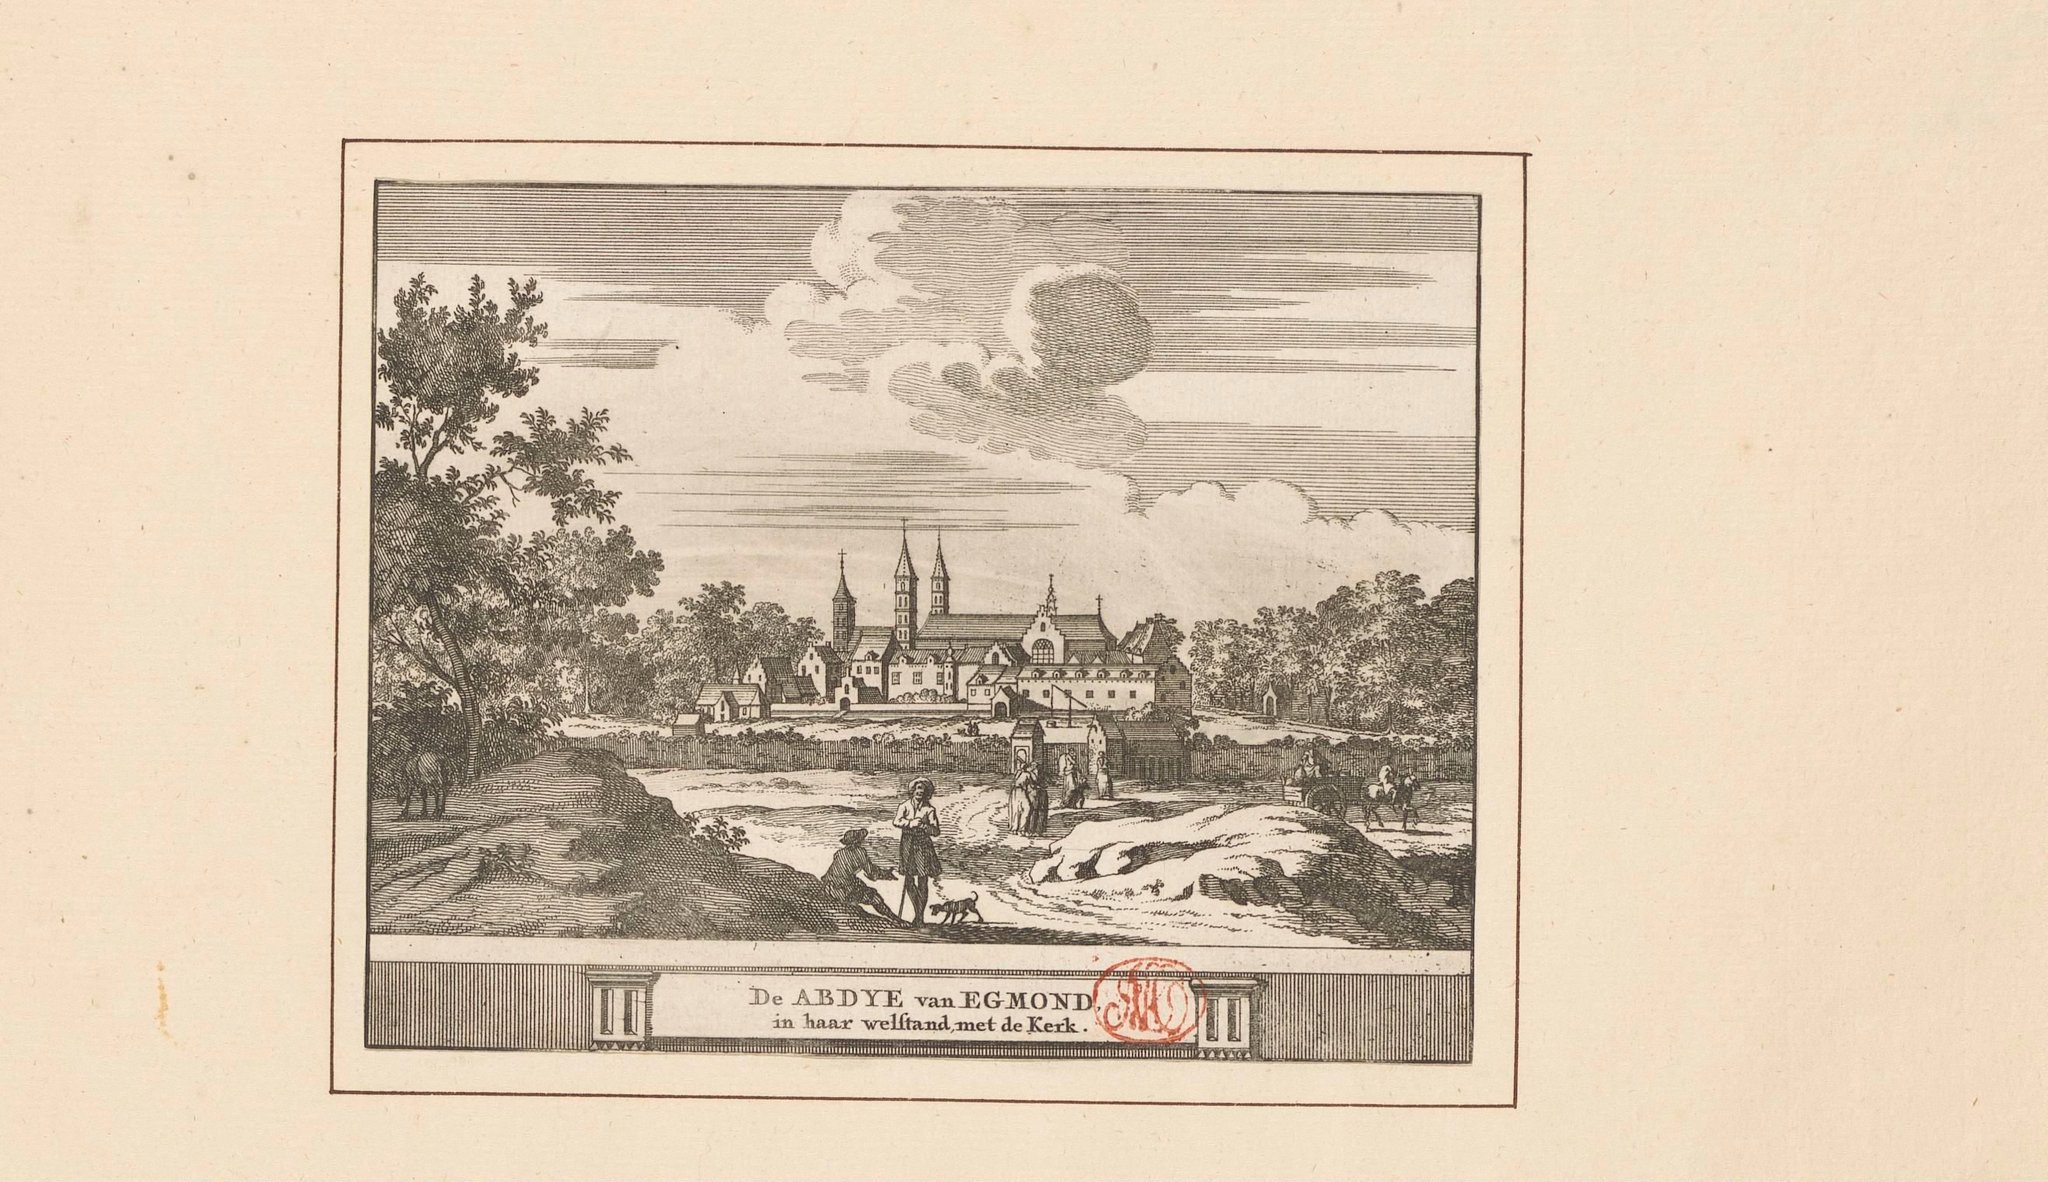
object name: print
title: De abdye van Egmond, in haar welstand, met de kerk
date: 1711-1774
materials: paper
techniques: engraving, etching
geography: amsterdam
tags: abbey, monastery, convent ~ roman catholic church, church (exterior)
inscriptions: collector's mark: Lugt 195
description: Prent ook gebruikt in: Smids, Ludolf. Schatkamer der Nederlandsse oudheden; of woordenboek, behelsende Nederlands steden en dorpen, kasteelen, sloten en heeren huysen (…). Amsterdam: Pieter de Coup, 1711, tussen p. 76 en 77. Het is ook mogelijk dat deze prent uit de tweede (1737) of derde (1774) druk komt, of uit een uitgave met alleen de prenten: Nederlandsche oudheden, bestaande in zestig verbeeldingen (...) gelegen in Holland, 't Sticht van Utrecht en Gelderland enz. Amsterdam: Hendrik Bosch, 1721.